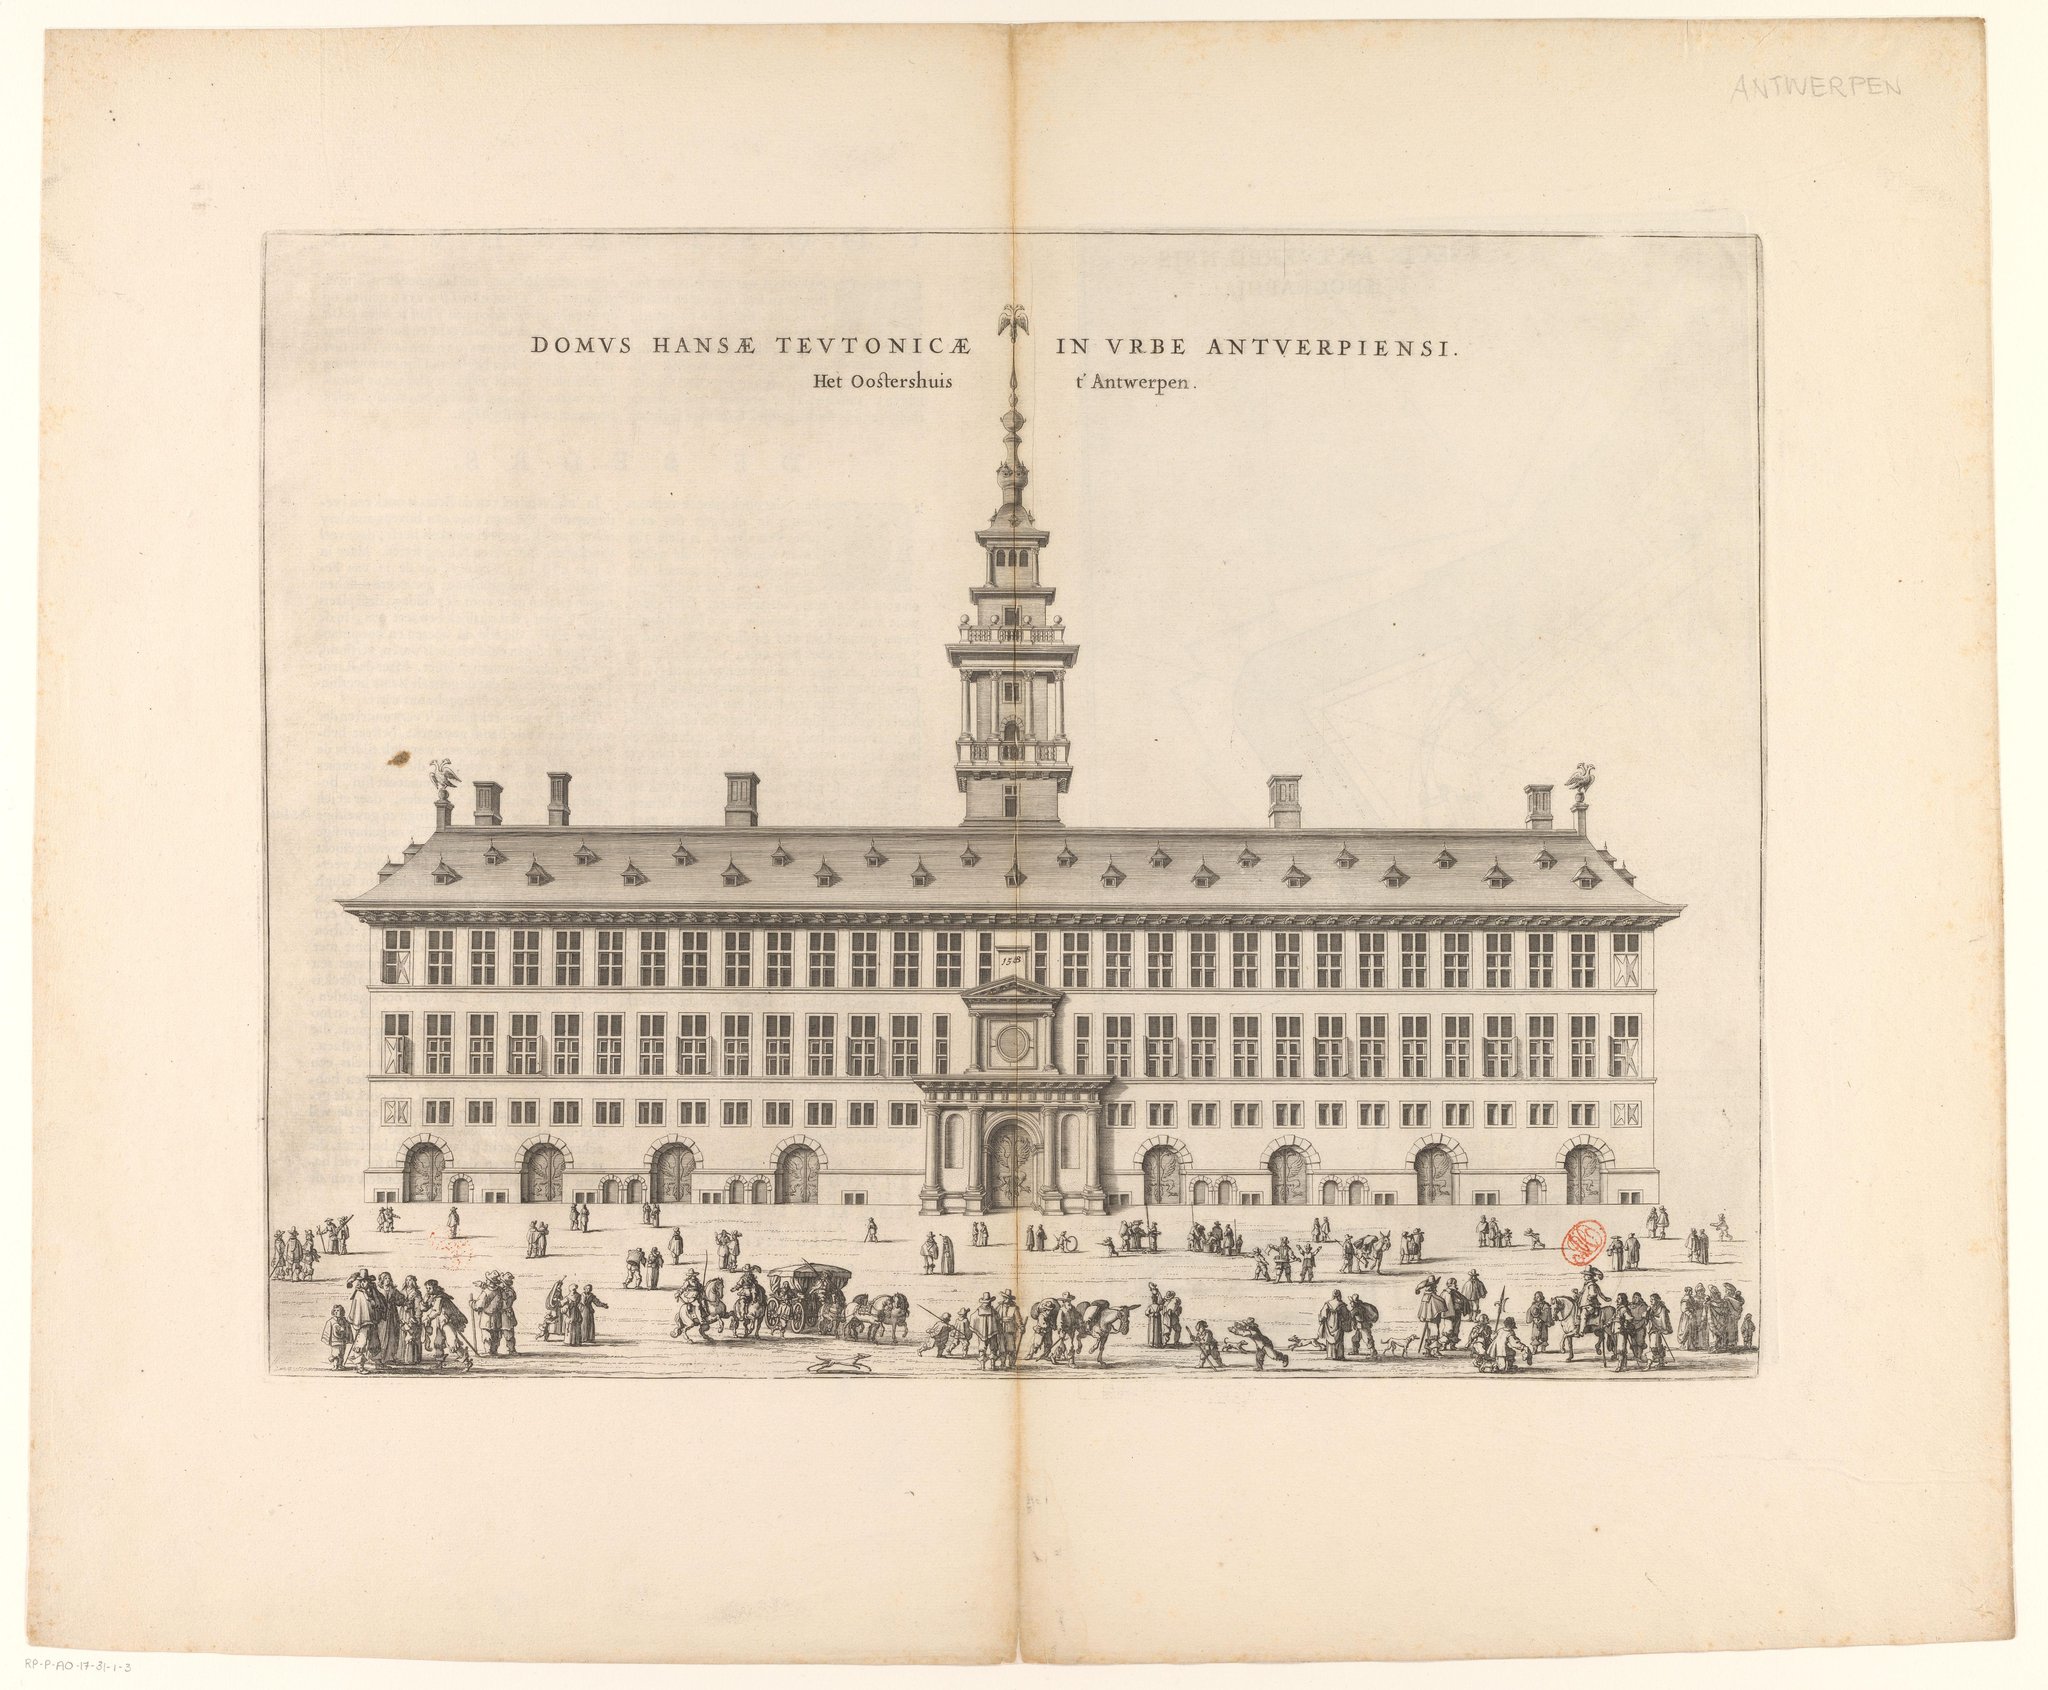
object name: print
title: Gezicht op het Oostershuis te Antwerpen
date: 1652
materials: paper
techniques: engraving, etching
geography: amsterdam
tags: locations for trading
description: Prent gebruikt in: Blaeu, Johannes Willemszoon. Toonneel der steden van de Vereenighde Nederlanden. 2 delen. Amsterdam: Johannes Willemszoon Blaeu, 1652, dl. 2.